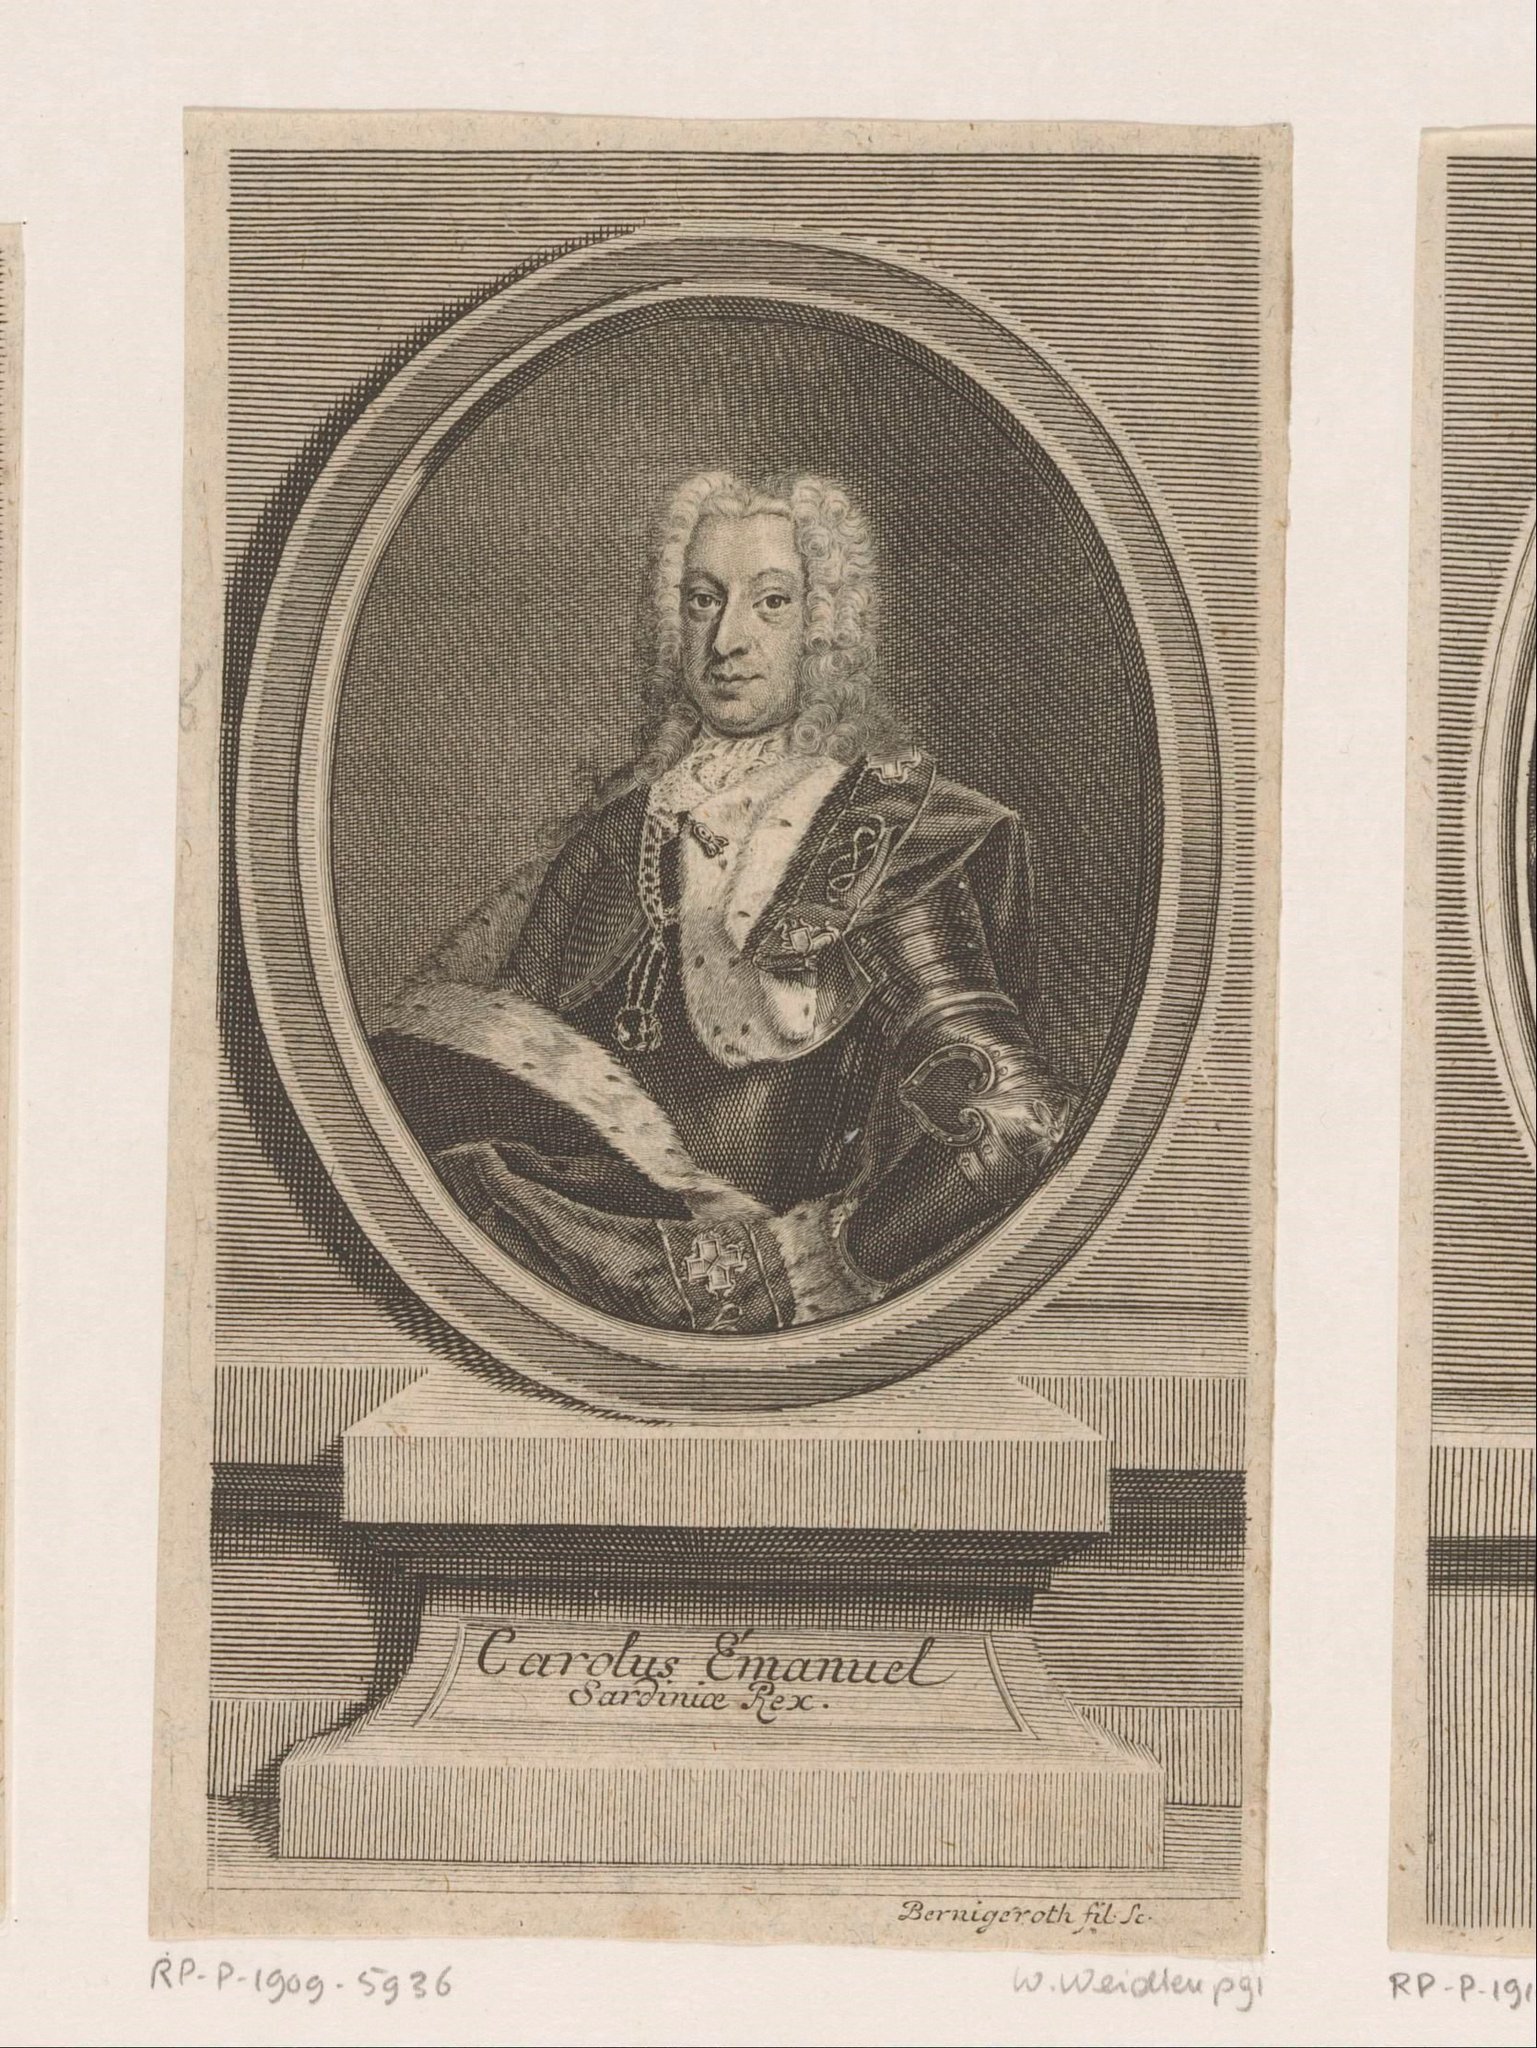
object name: print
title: Portret van Karel Emanuel III van Sardinië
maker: johann martin bernigeroth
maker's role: print maker, publisher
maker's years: 1713-1767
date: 1730-1767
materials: paper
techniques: engraving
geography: leipzig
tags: karel emanuel iii (koning van sardinië), armour, historical persons, mantle, gown, dress (symbol of sovereignty), knighthood order of the golden fleece - insignia of a knighthood order, e.g.: badge, chain (with name of order)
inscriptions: collector's mark: Lugt 2228